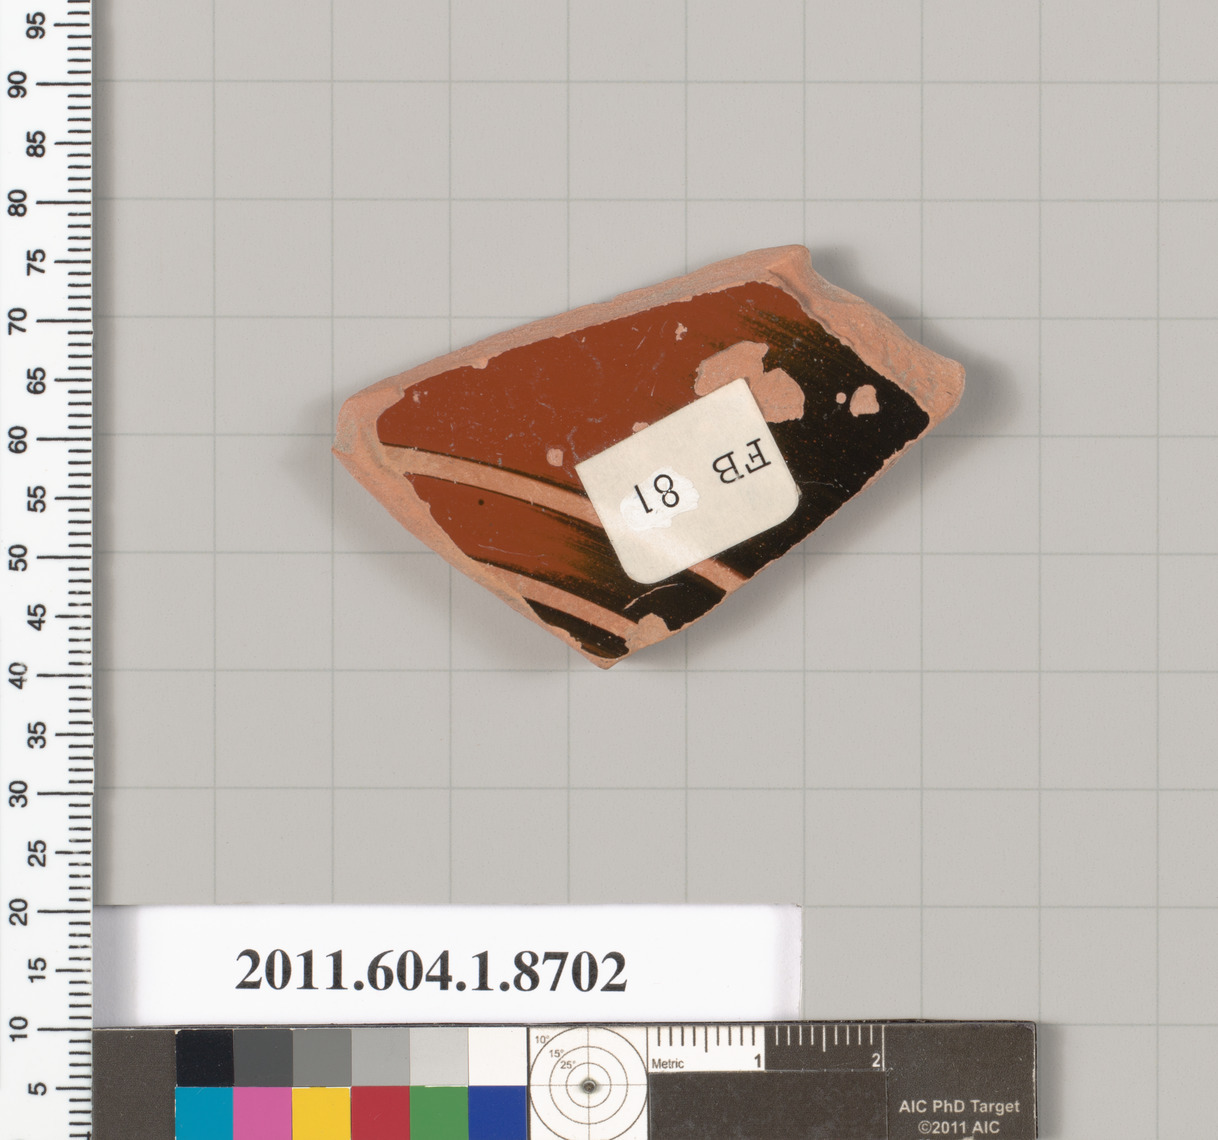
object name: kylix fragment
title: Terracotta fragment of a stemless kylix (drinking cup)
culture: greek, attic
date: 430-420 BCE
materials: terracotta